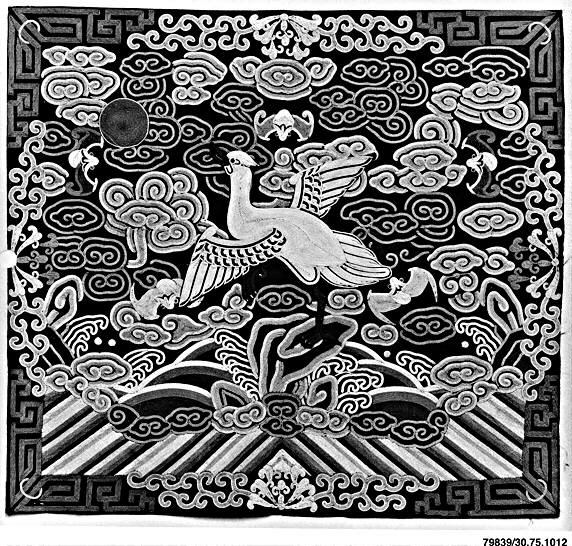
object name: woman's rank badge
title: Woman's Rank Badge with Egret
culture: chinese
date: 1767-1833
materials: silk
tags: bats,birds